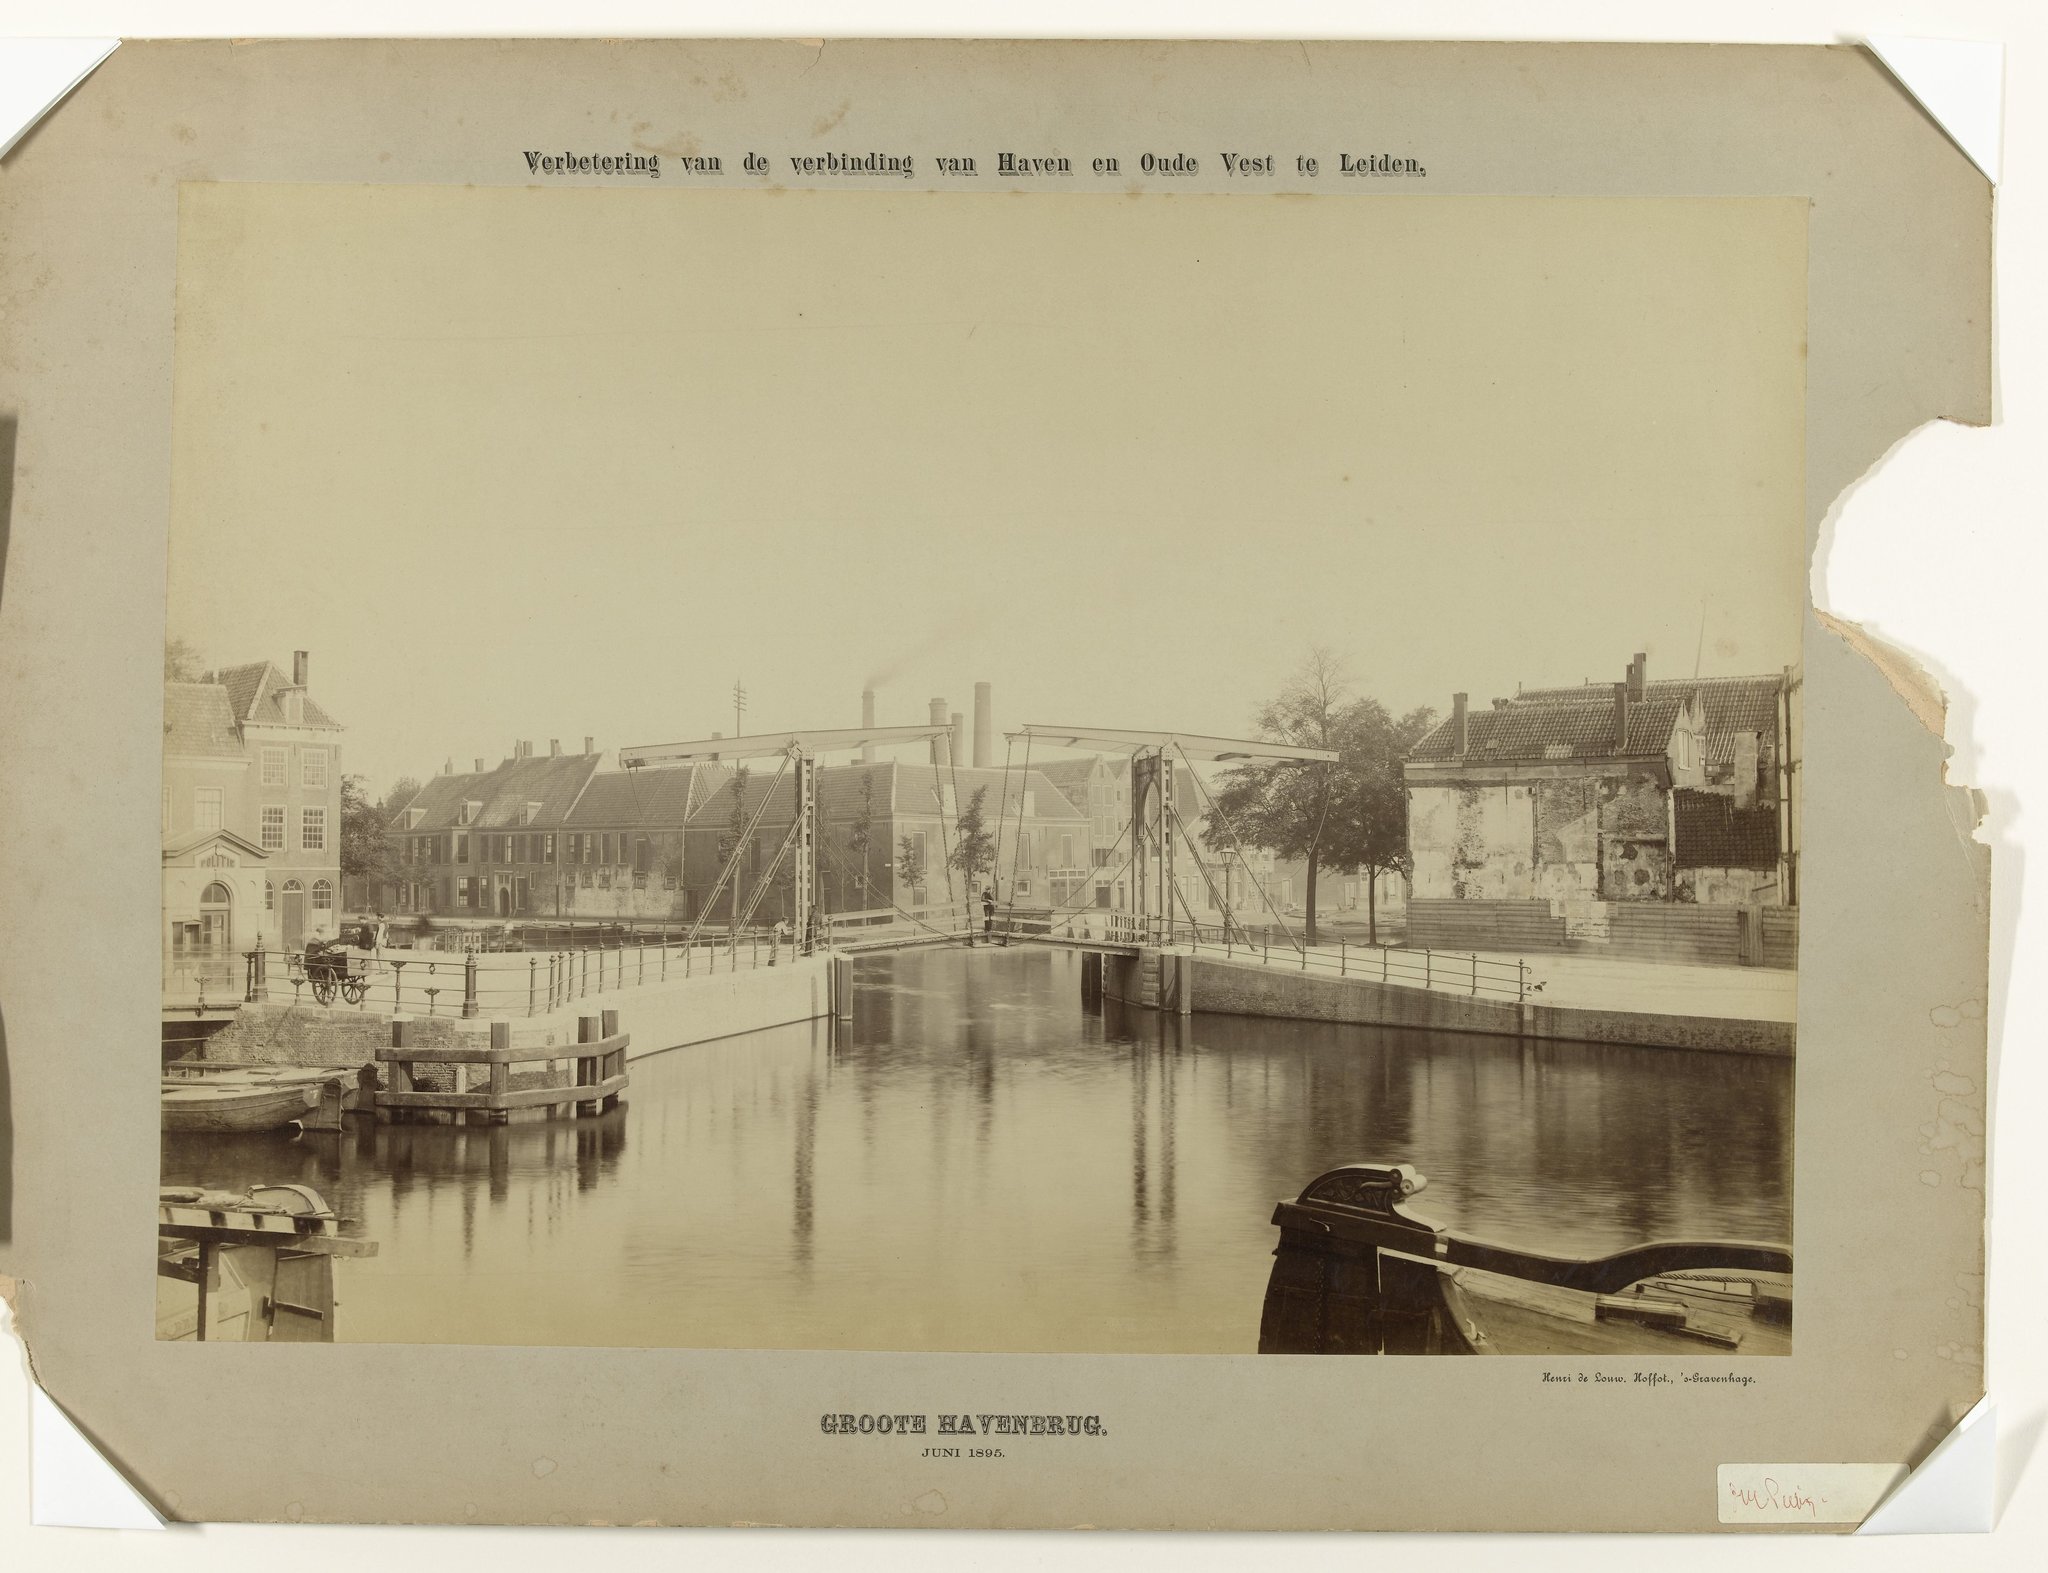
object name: photograph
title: Grote Havenbrug te Leiden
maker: henri de louw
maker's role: fotograaf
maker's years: 1851-1944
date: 1806-1895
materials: cardboard, photographic support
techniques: albumen print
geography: the hague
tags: bridge in city across river, canal, etc.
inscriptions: date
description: Grote Havenbrug te Leiden in de nieuwe situatie met de dubbele ophaalbrug die werd geplaatst in 1894-1895.